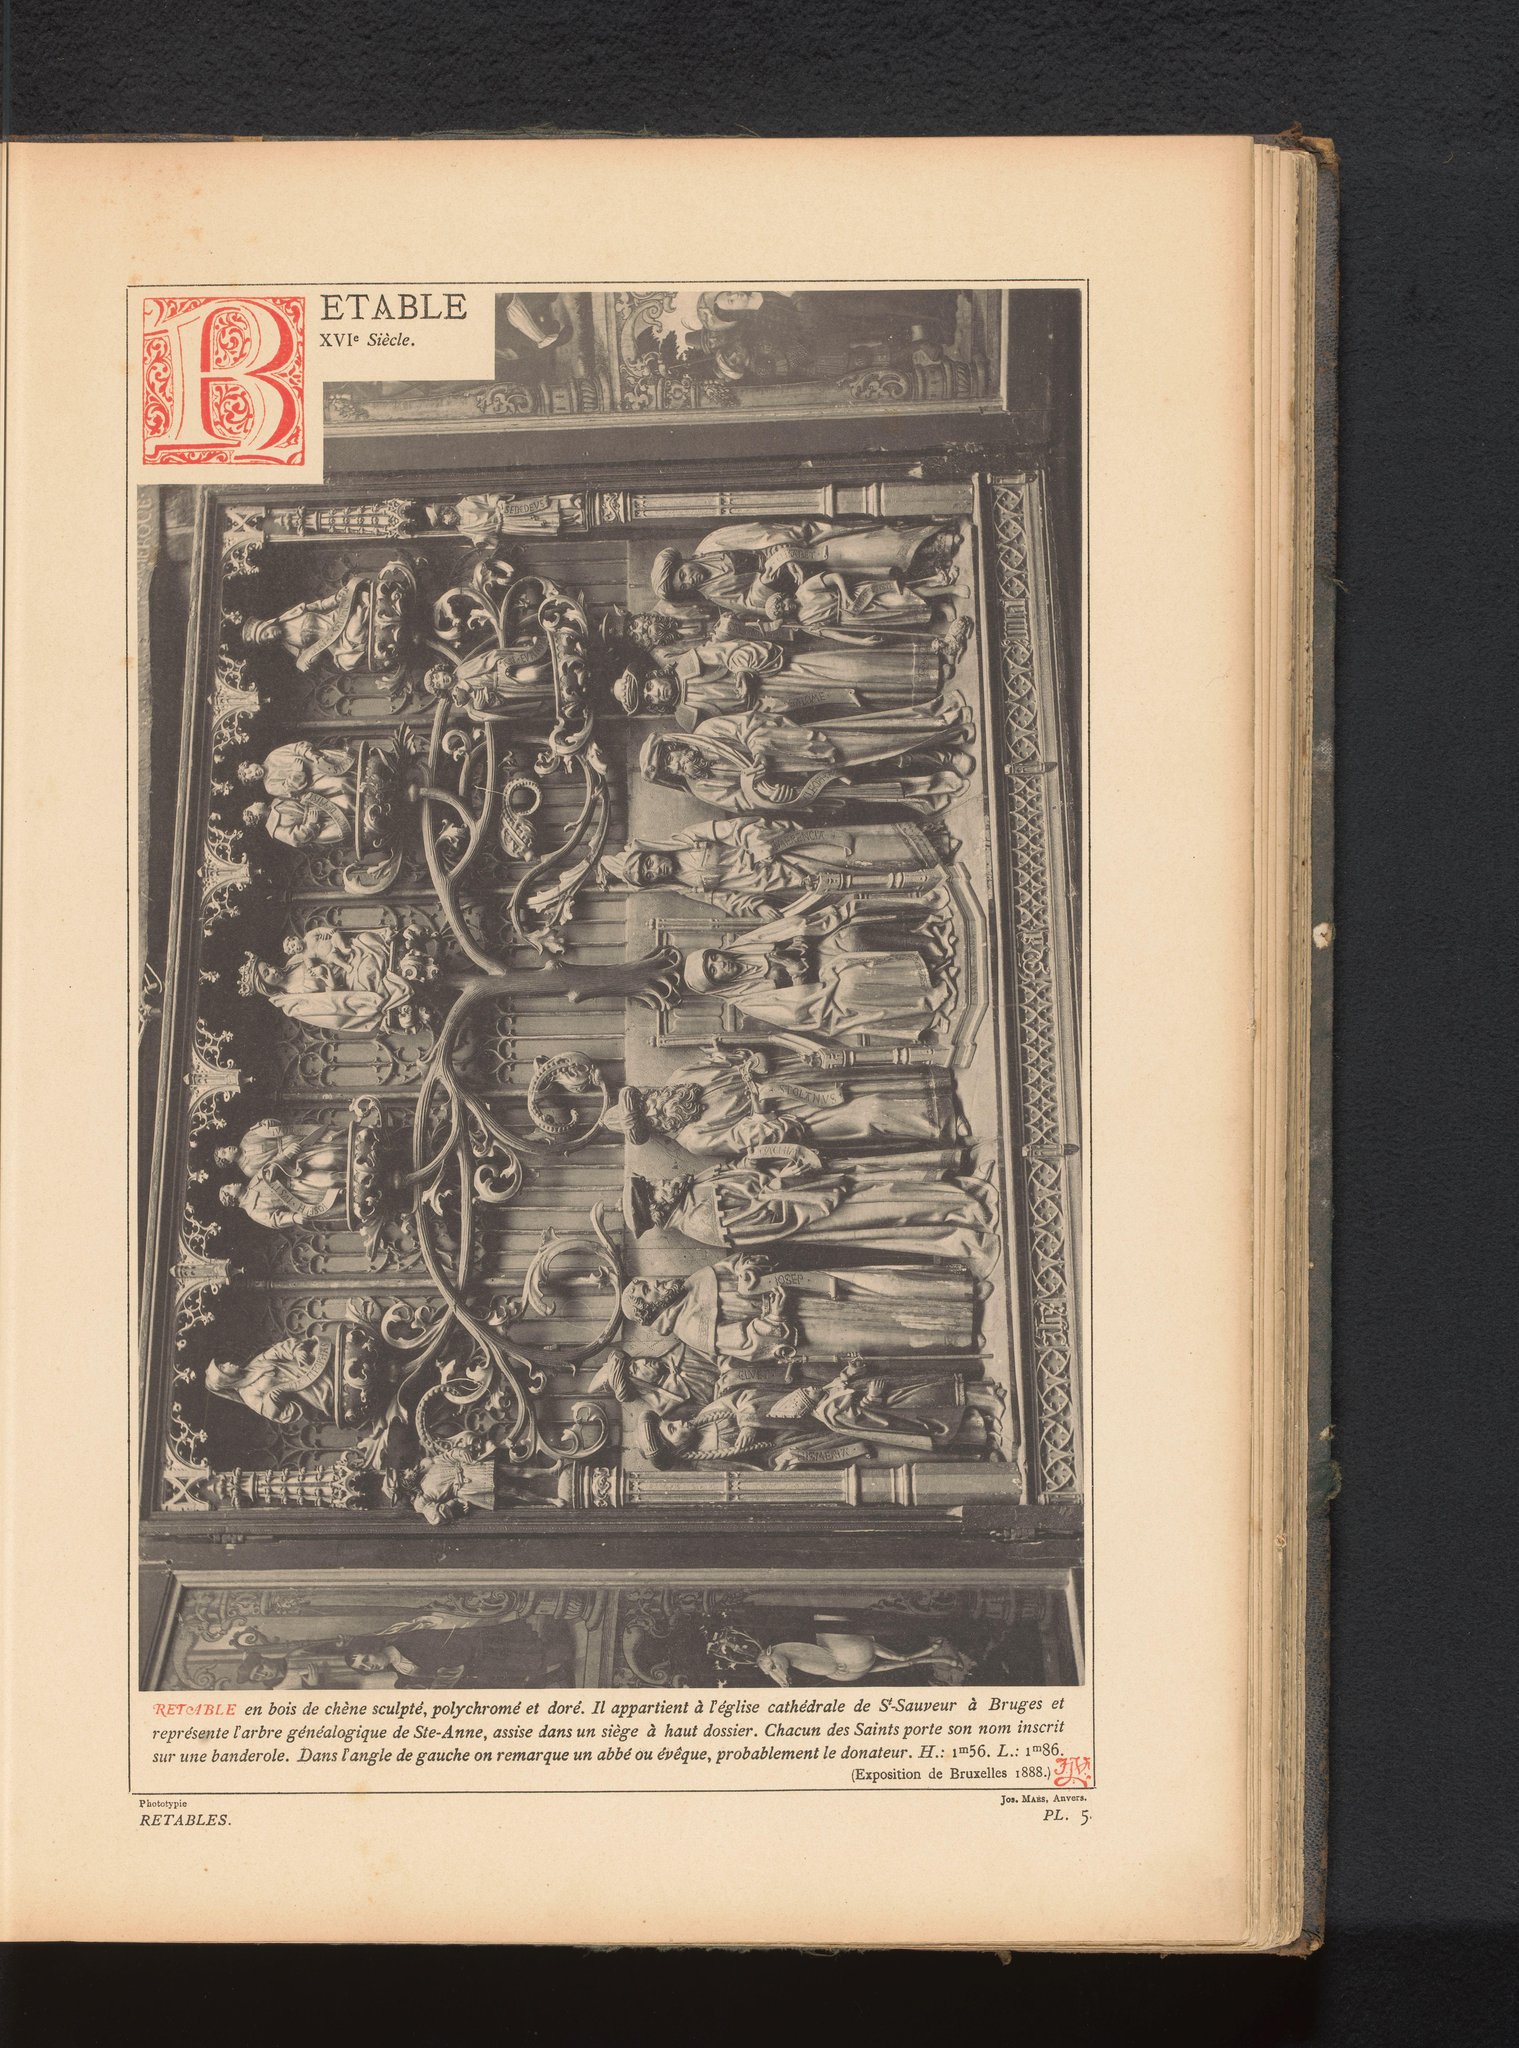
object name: photomechanical print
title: Altaarstuk van eikenhout, afgebeeld de stamboom van de heilige Anna, in de Sint-Salvatorskathedraal in Brugge, België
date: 1882-1887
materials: paper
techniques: photograph, photolithography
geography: sint-salvatorskathedraal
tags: anna, mother of mary; possible attributes: book, christ-child, lily, virgin mary, altar with altar-piece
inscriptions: inscription: ‘RETABLE en bois (...)’, monogram: ‘JJvY’, inscription: ‘RETABLES. - PL. 5.’